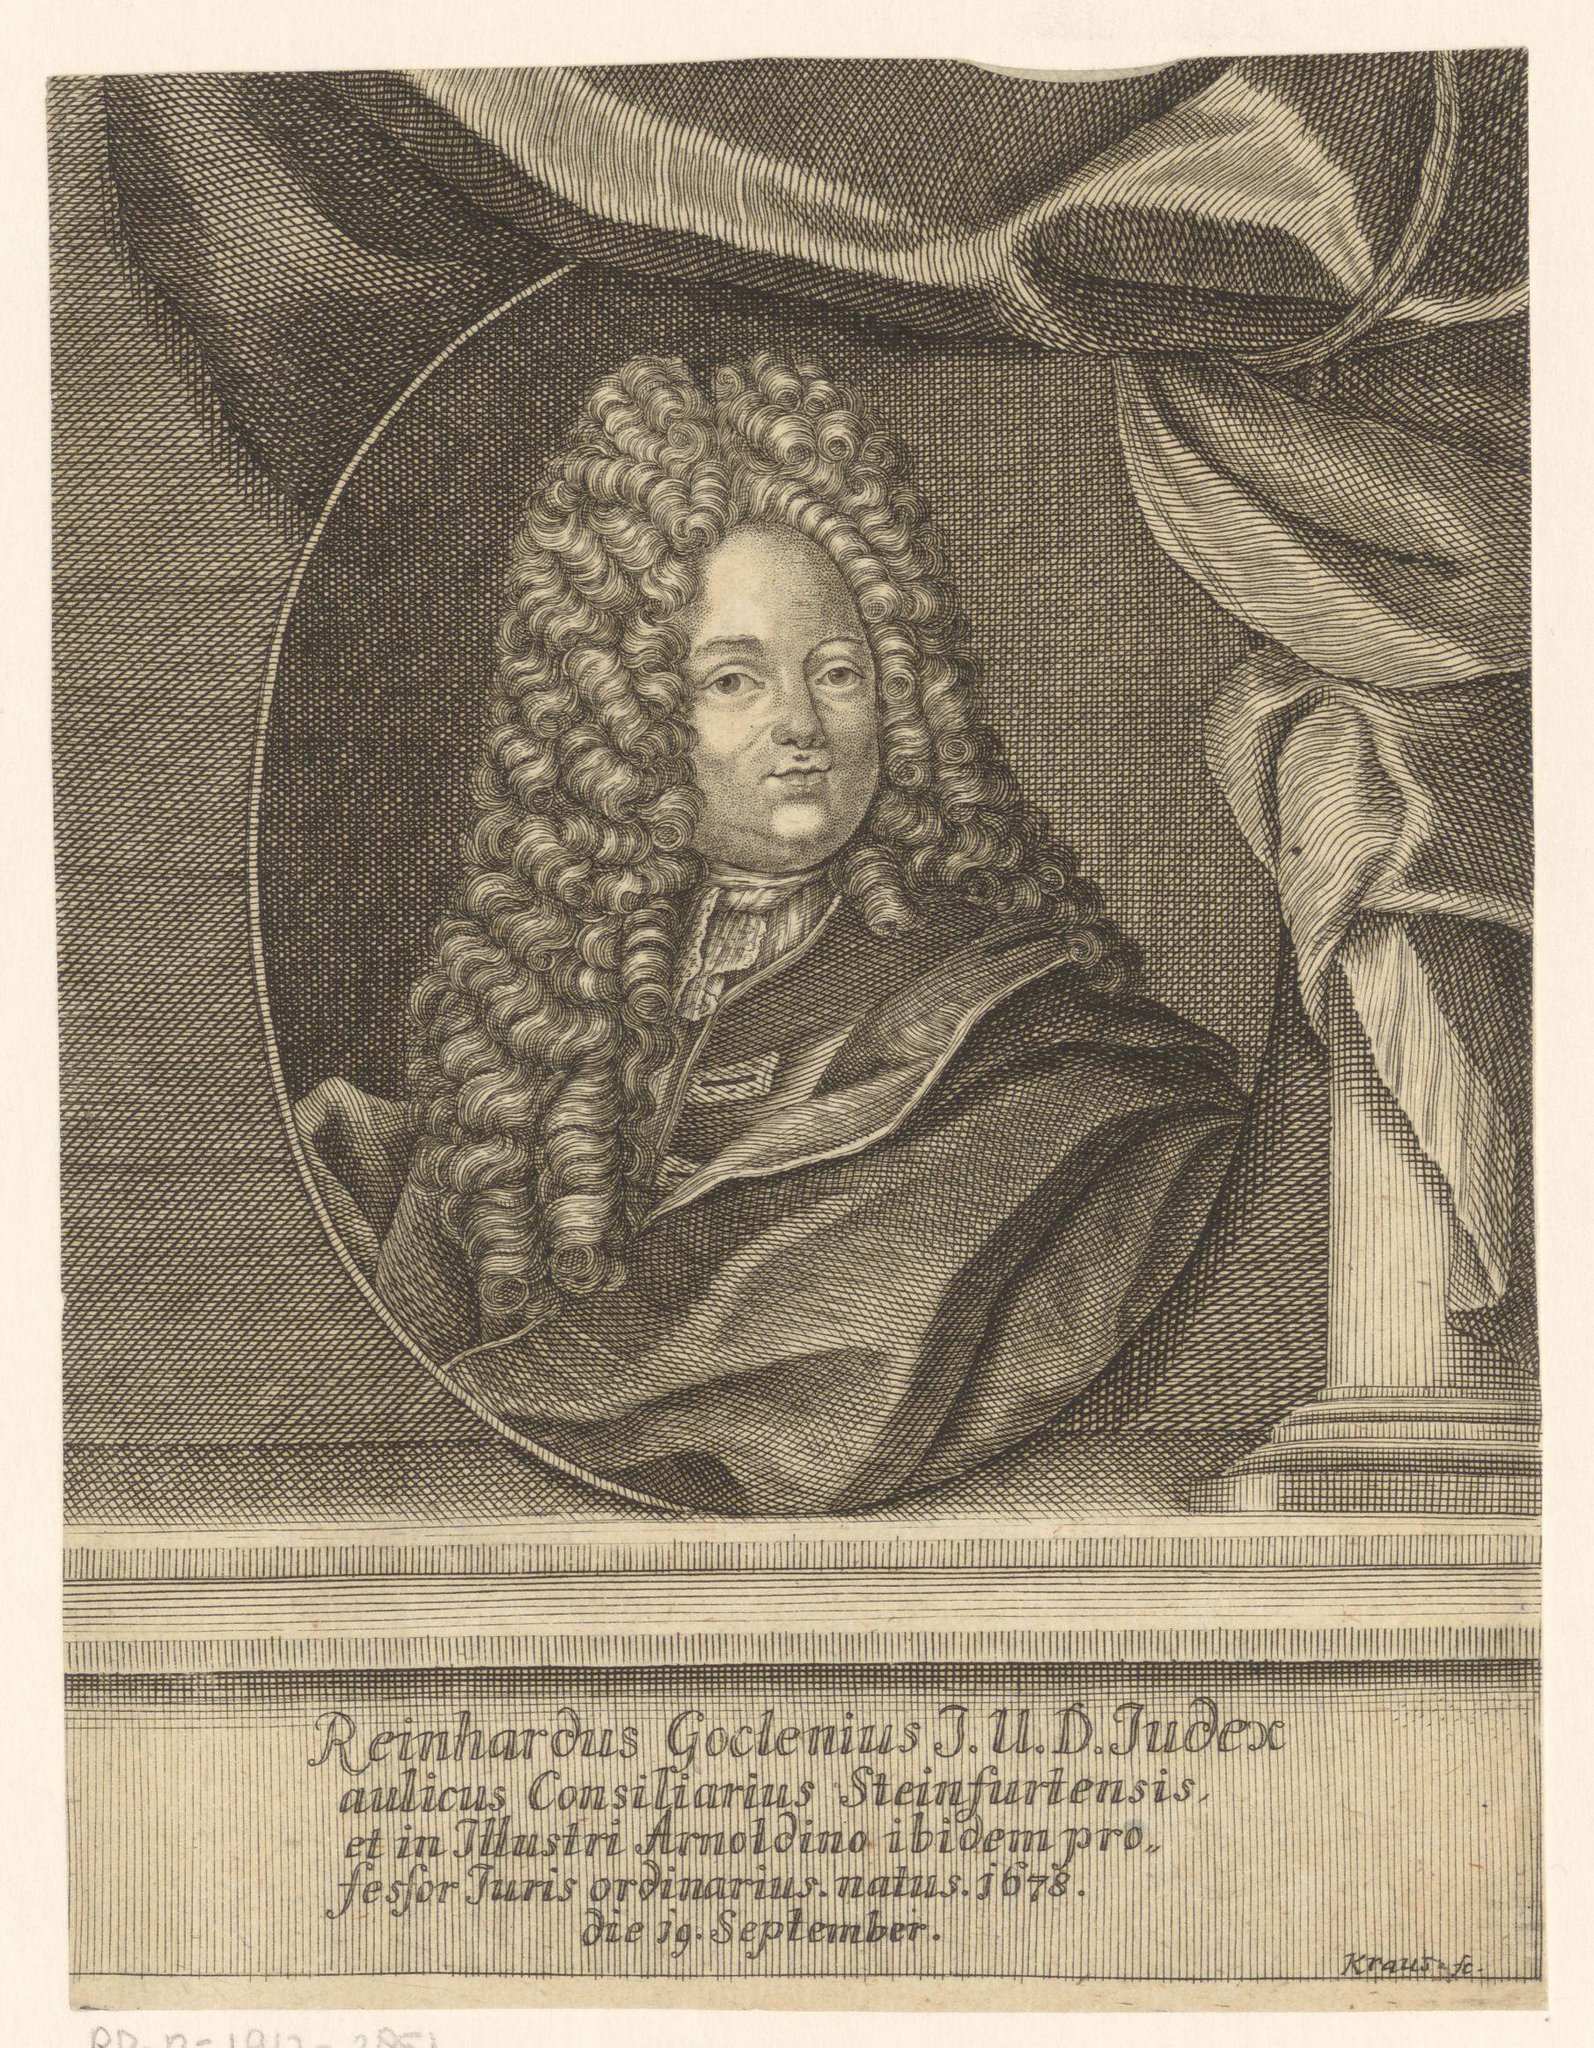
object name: print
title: Portret van Reinhard Goclenius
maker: jodocus egidius krauss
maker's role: print maker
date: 1705-1725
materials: paper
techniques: engraving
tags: reinhard goclenius, historical persons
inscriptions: collector's mark: Lugt 2228